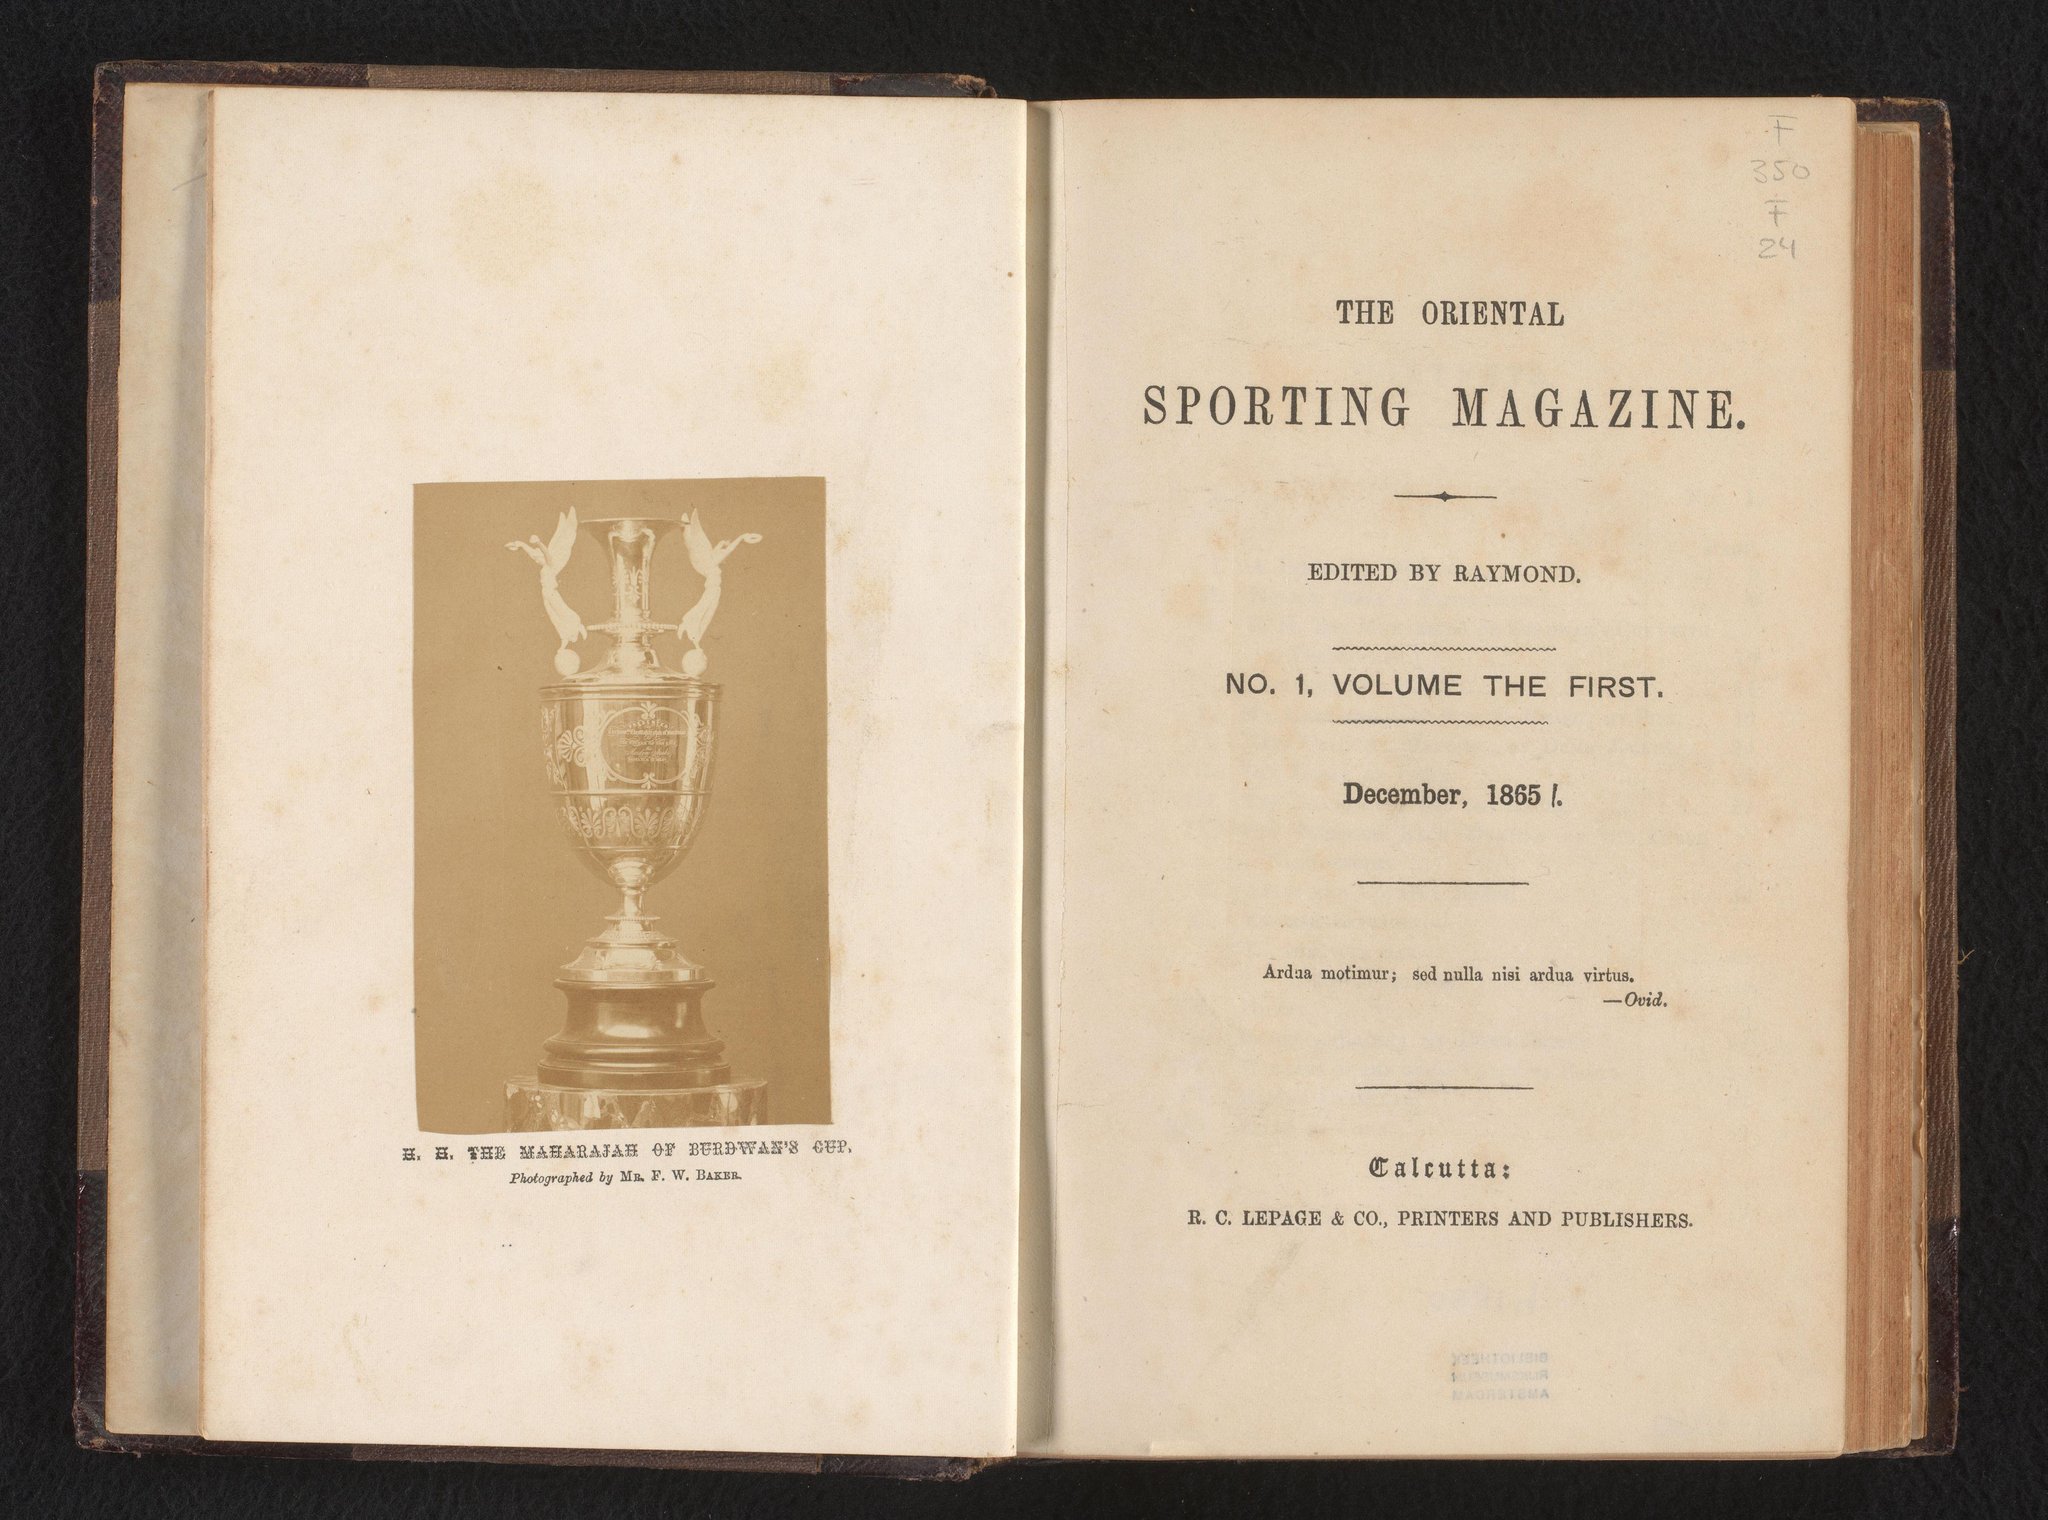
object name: book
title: The Oriental sporting magazine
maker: raymond (schrijver)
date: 1865-1867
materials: cardboard, leather, linen, paper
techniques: albumen print, letterpress printing, lithograph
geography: kolkata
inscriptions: inscription: ‘2/25/ Dec 1865 - Dec 1866/ > Maclet[?] Photos/ (...)/ by F.W. Baker.’